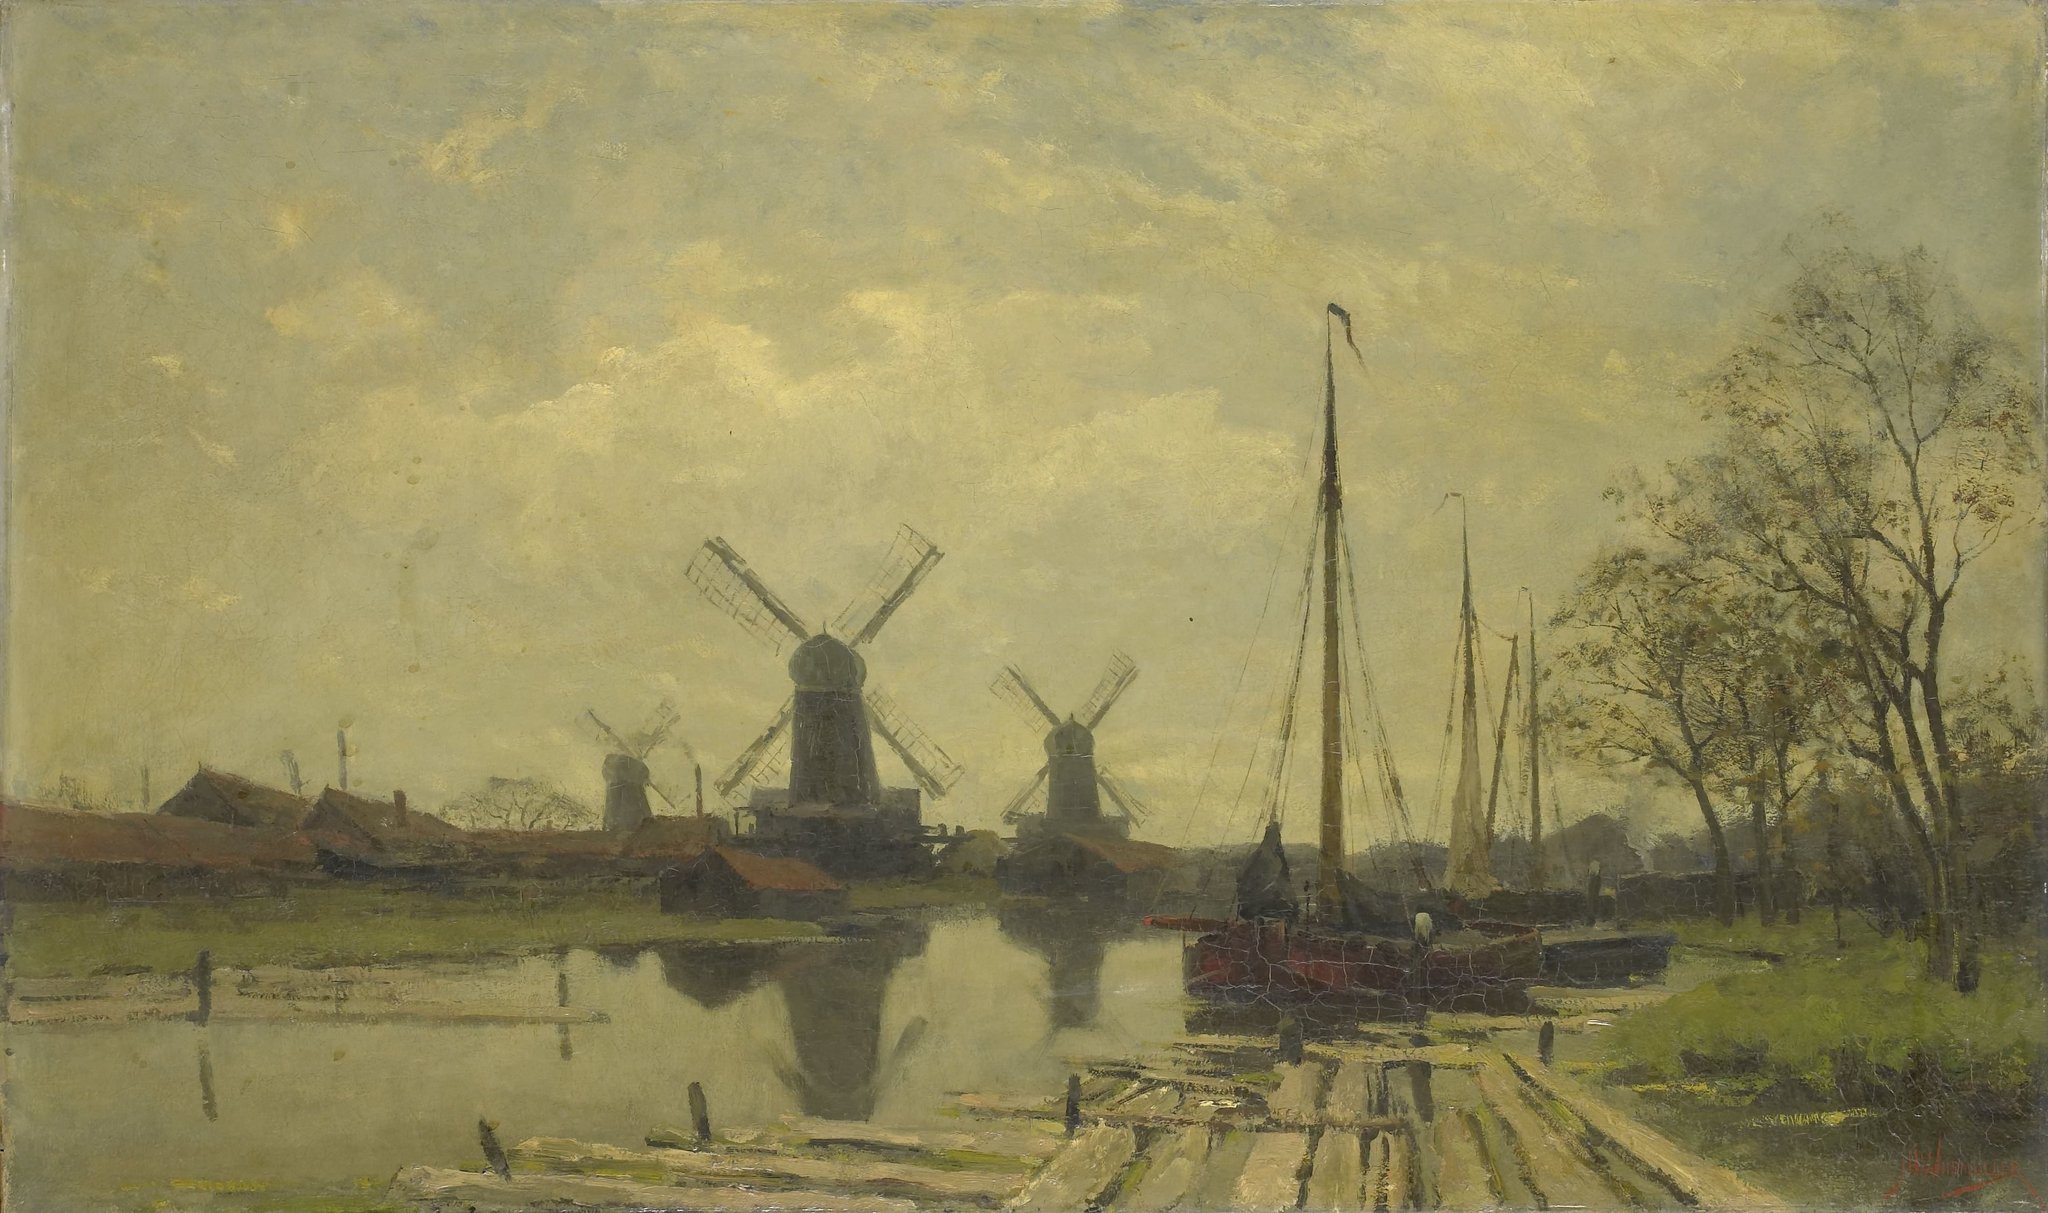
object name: painting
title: Waterway near the Baarsjes, Amsterdam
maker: jan hillebrand wijsmuller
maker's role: painter, print maker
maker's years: 1855-1925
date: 1880-1901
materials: canvas, oil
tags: sailing-ship, sailing-boat, freight vessel, canals, waters (in city), windmill, amsterdam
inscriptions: signature: ‘J.H. Wijsmuller’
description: Wetering bij de Baarsjes bij Amsterdam. Achter de steiger liggen enkele schuiten aan de waterkant, in de verte drie molens.